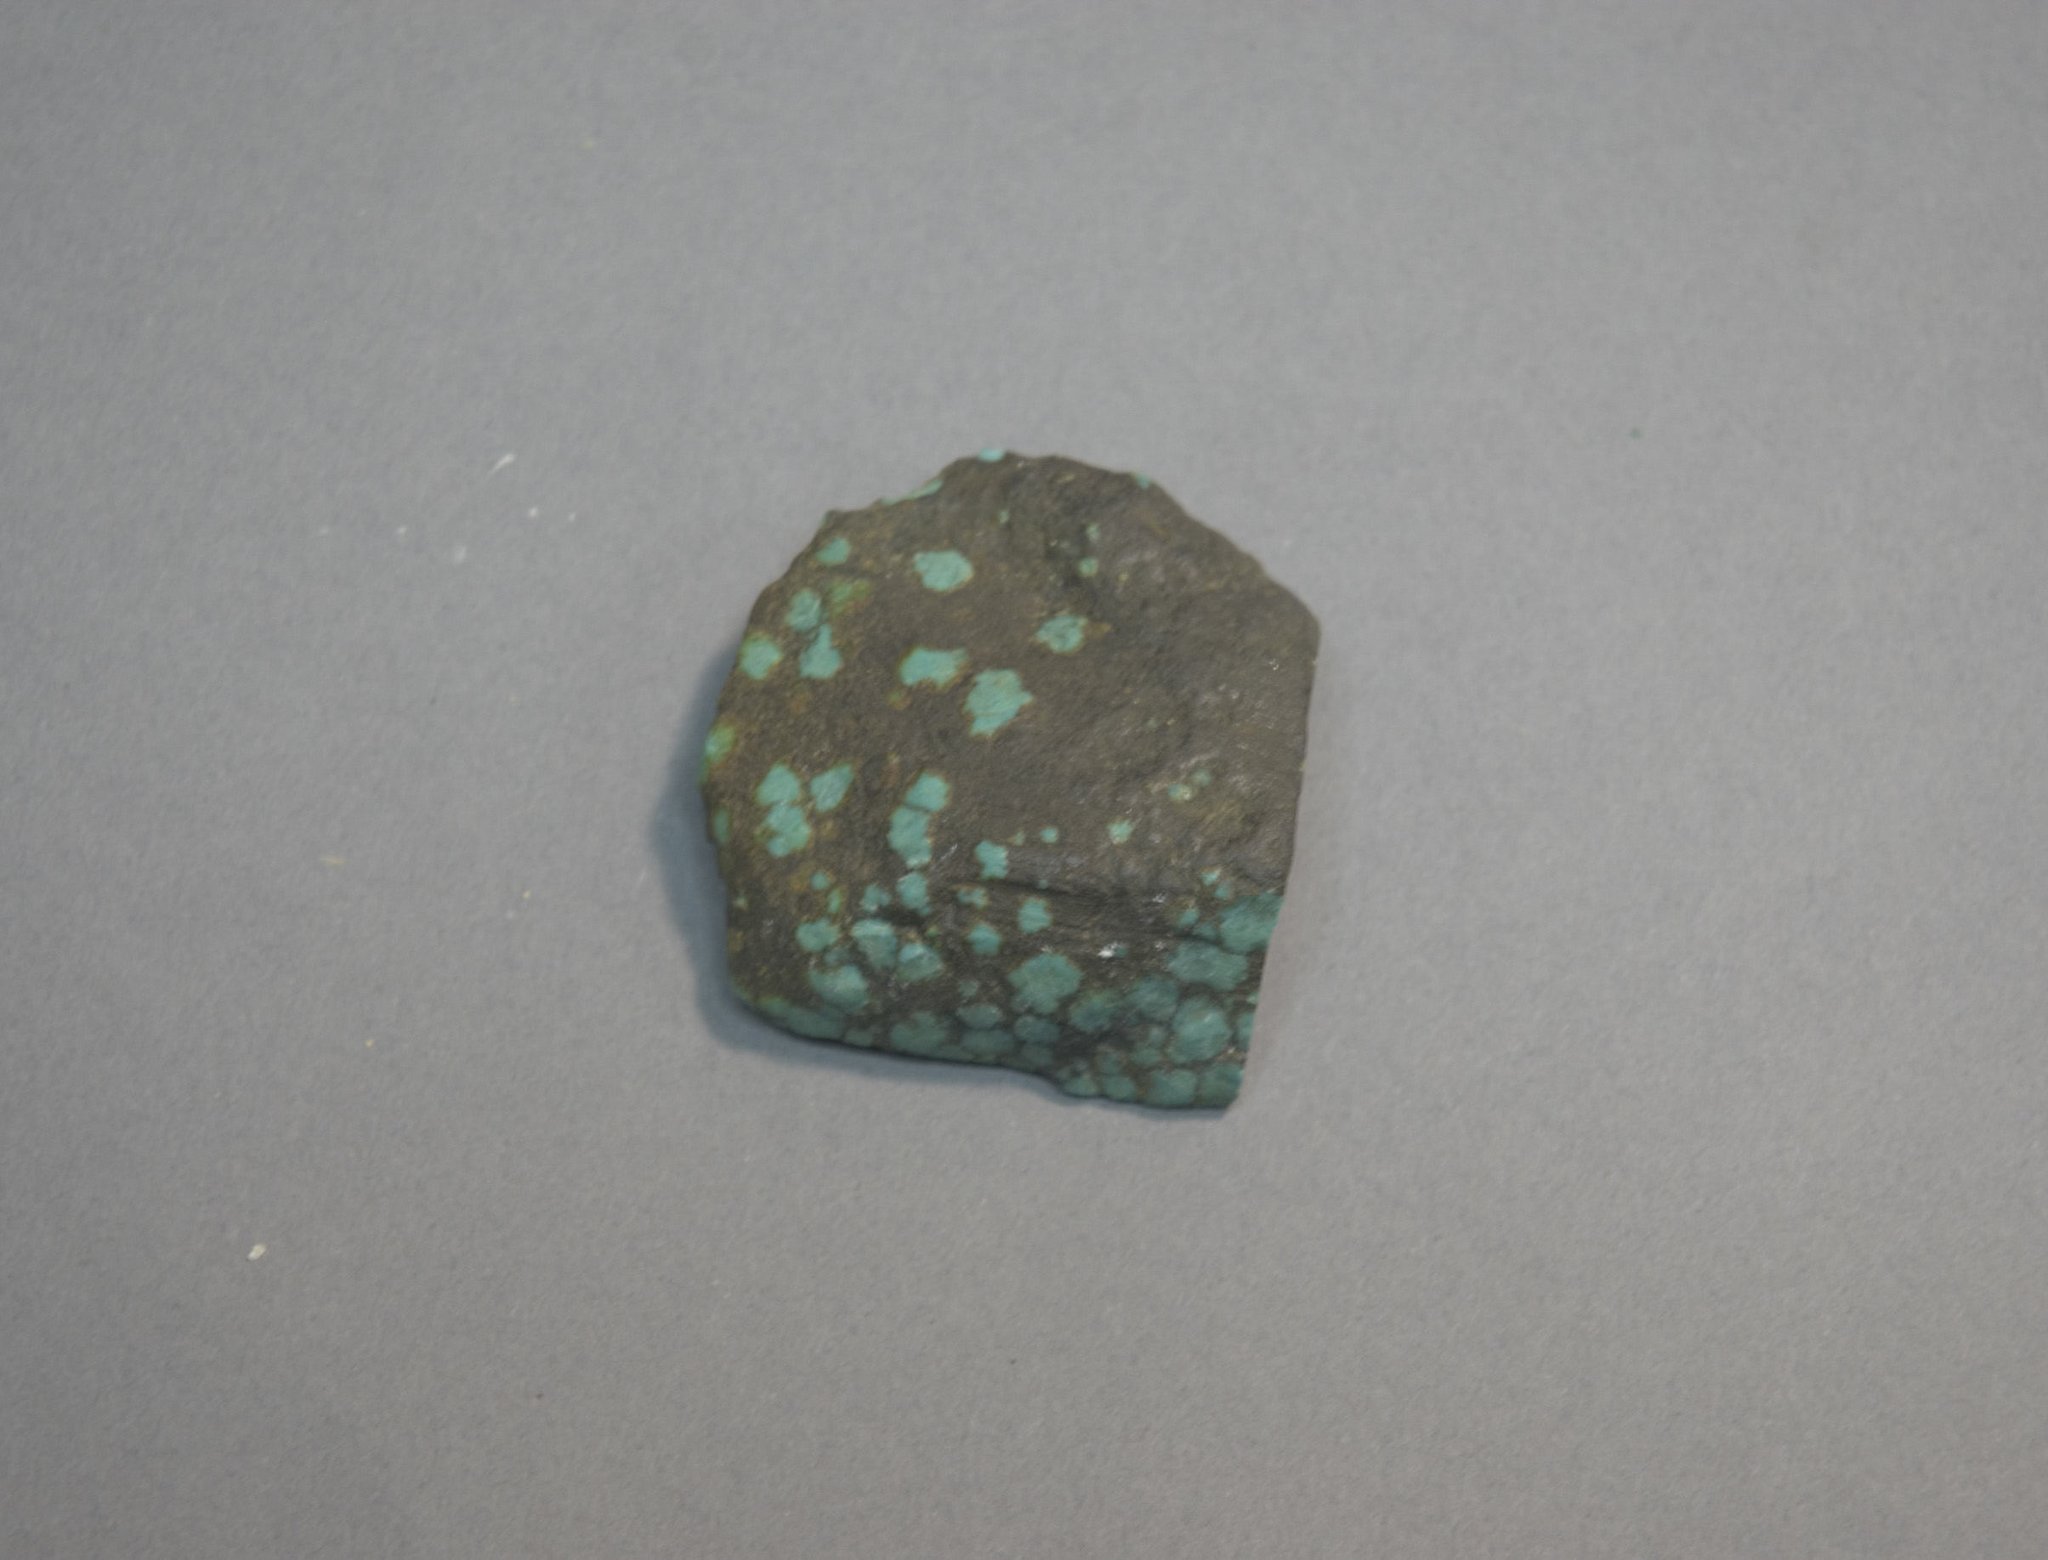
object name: jade carving material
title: Sample of Turquoise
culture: chinese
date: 1901-2000